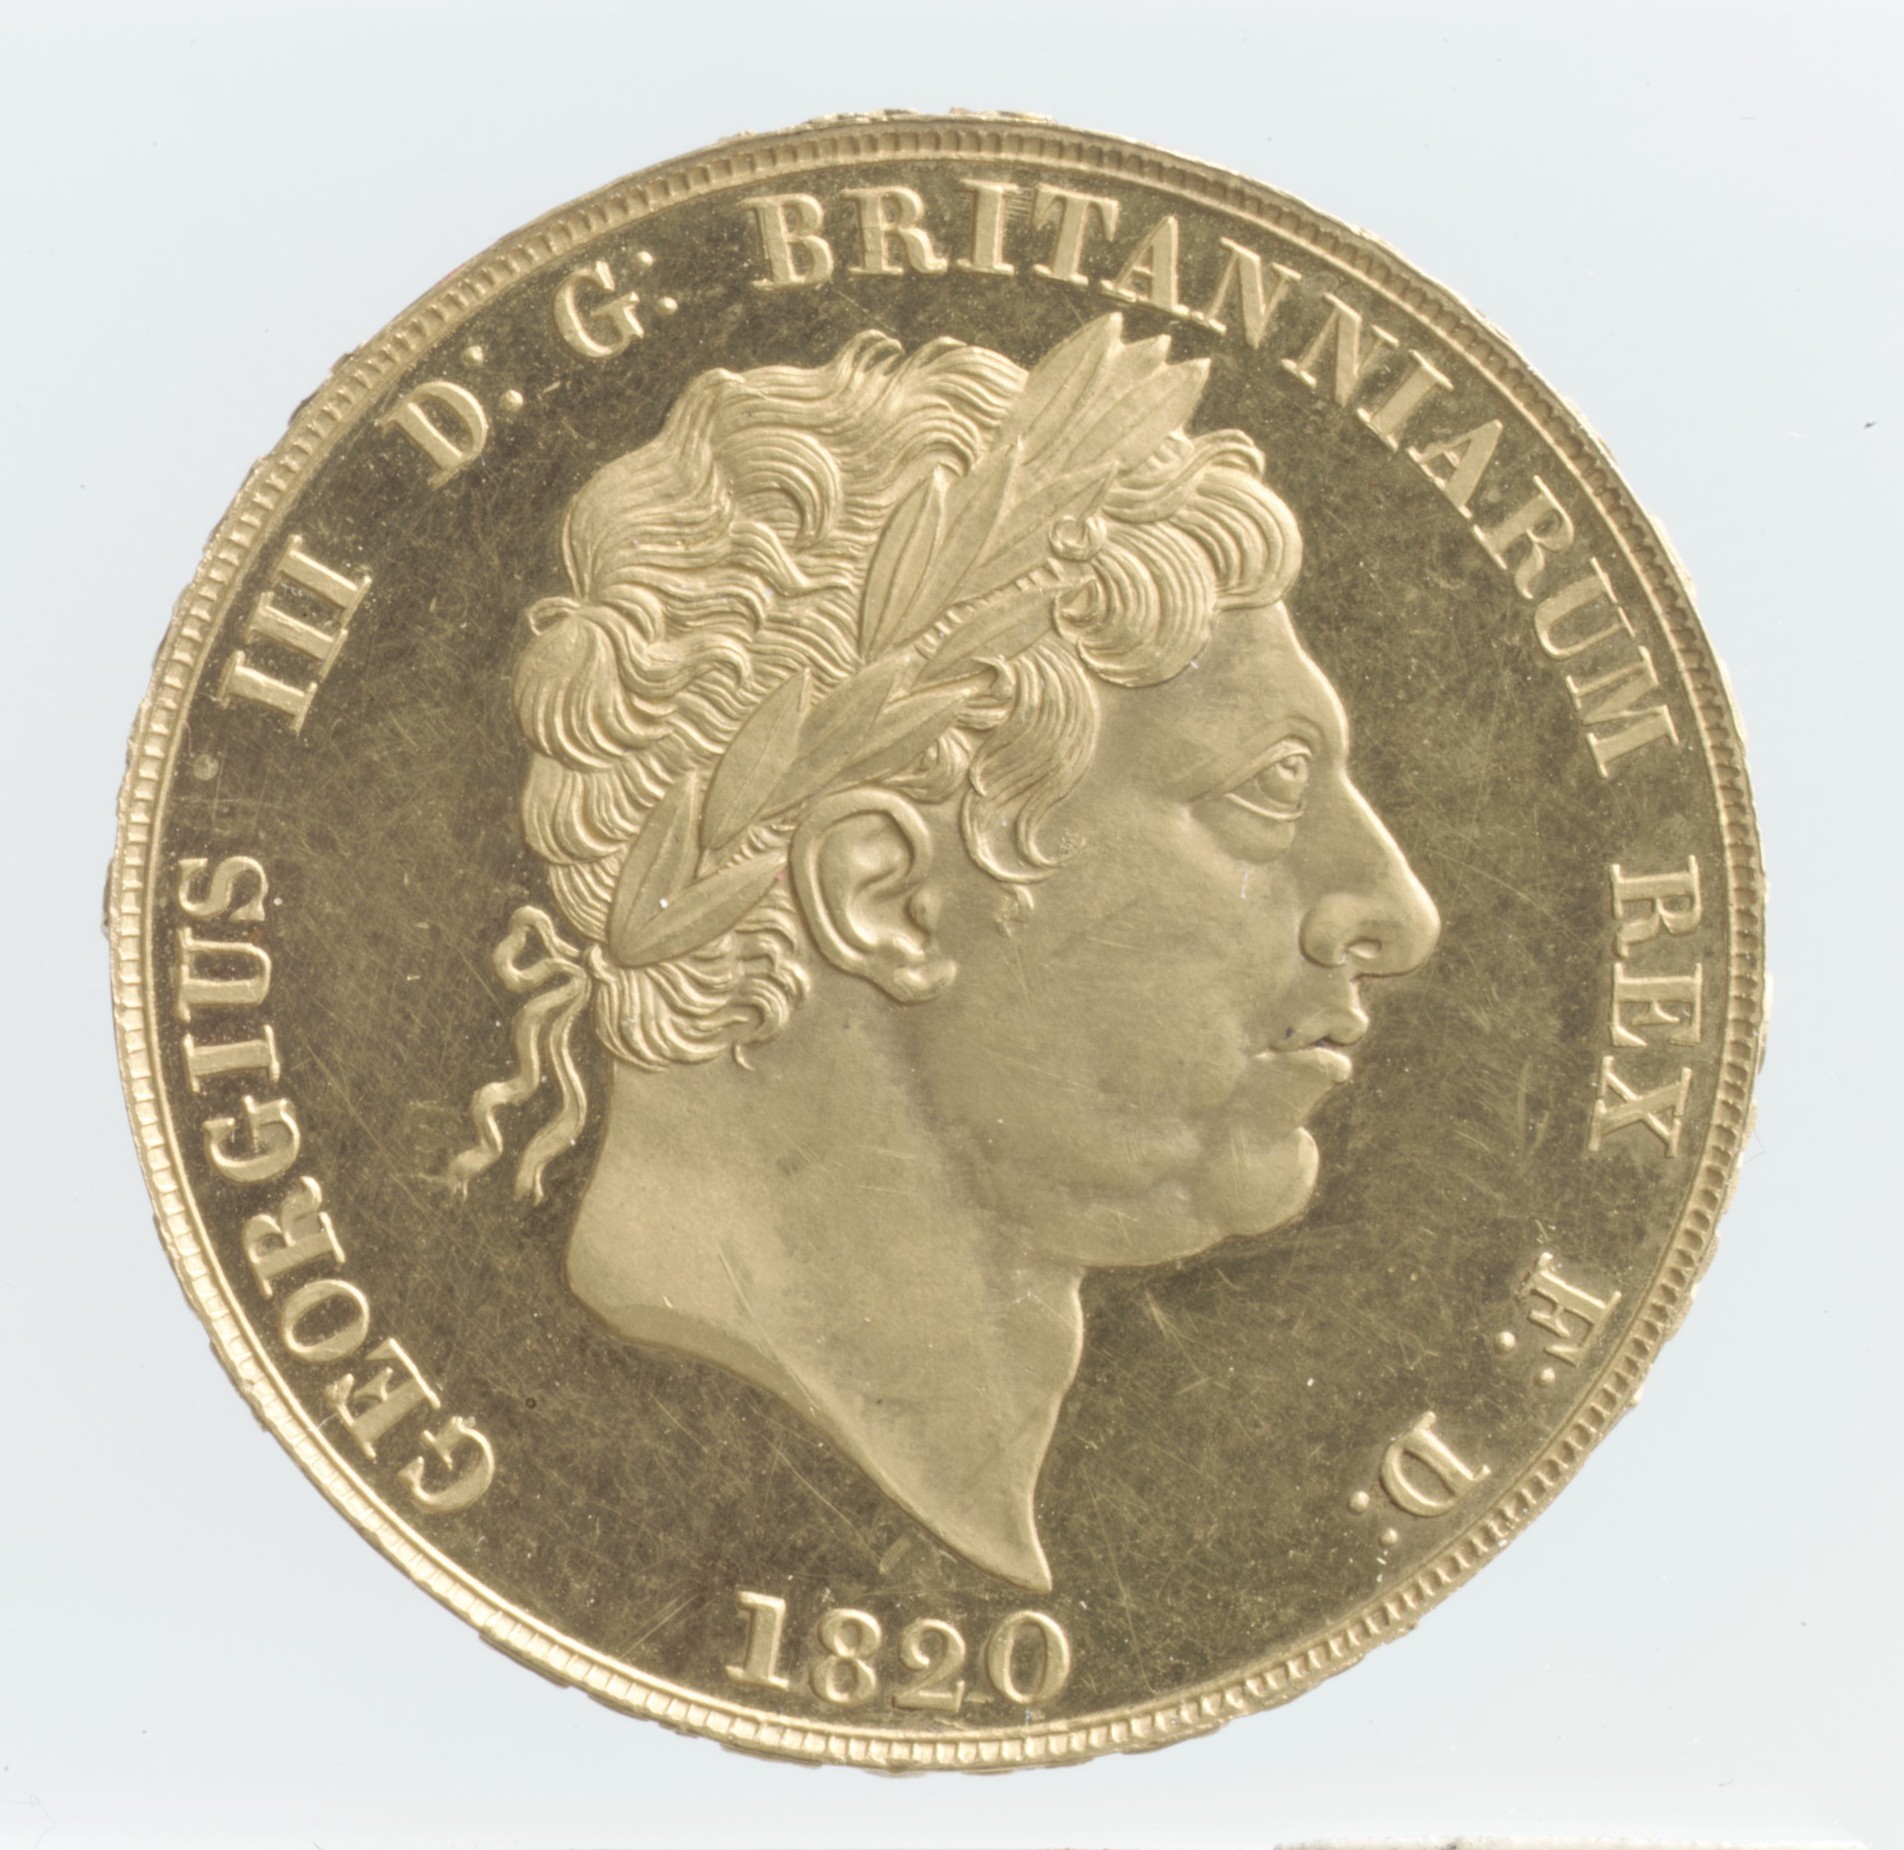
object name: double sovereign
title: George III double sovereign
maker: benedetto pistrucci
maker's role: maker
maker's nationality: italian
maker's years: 1783-1855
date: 1820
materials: gold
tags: kings,profiles,dragons,horses